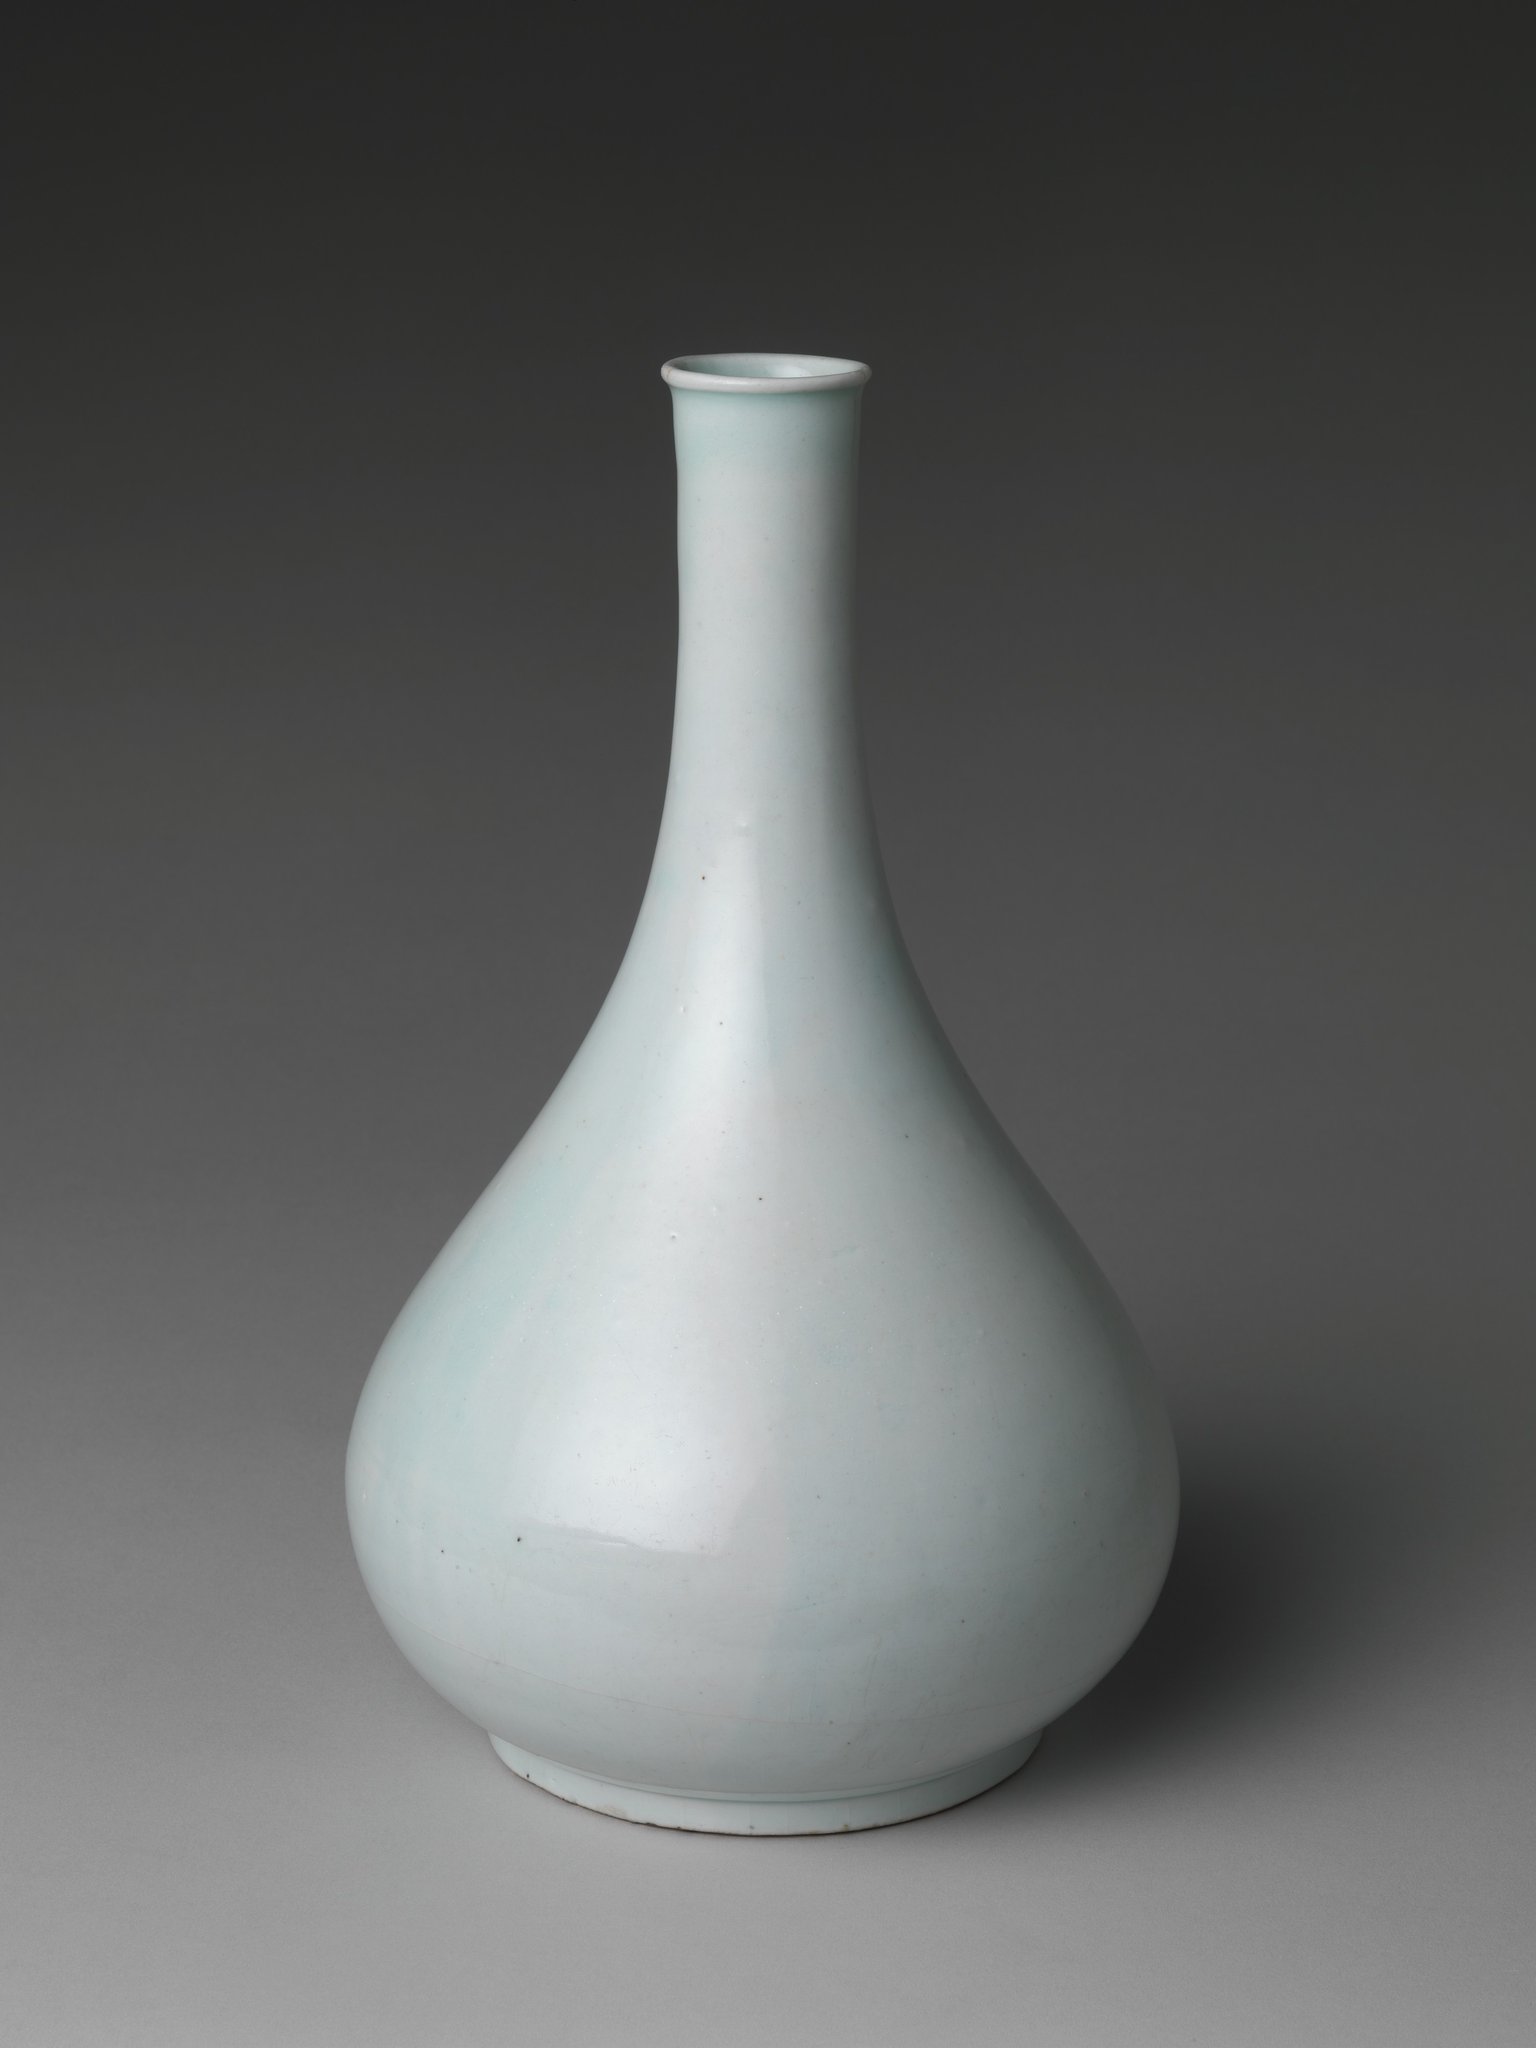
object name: bottle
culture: korean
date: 1801-1900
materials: porcelain